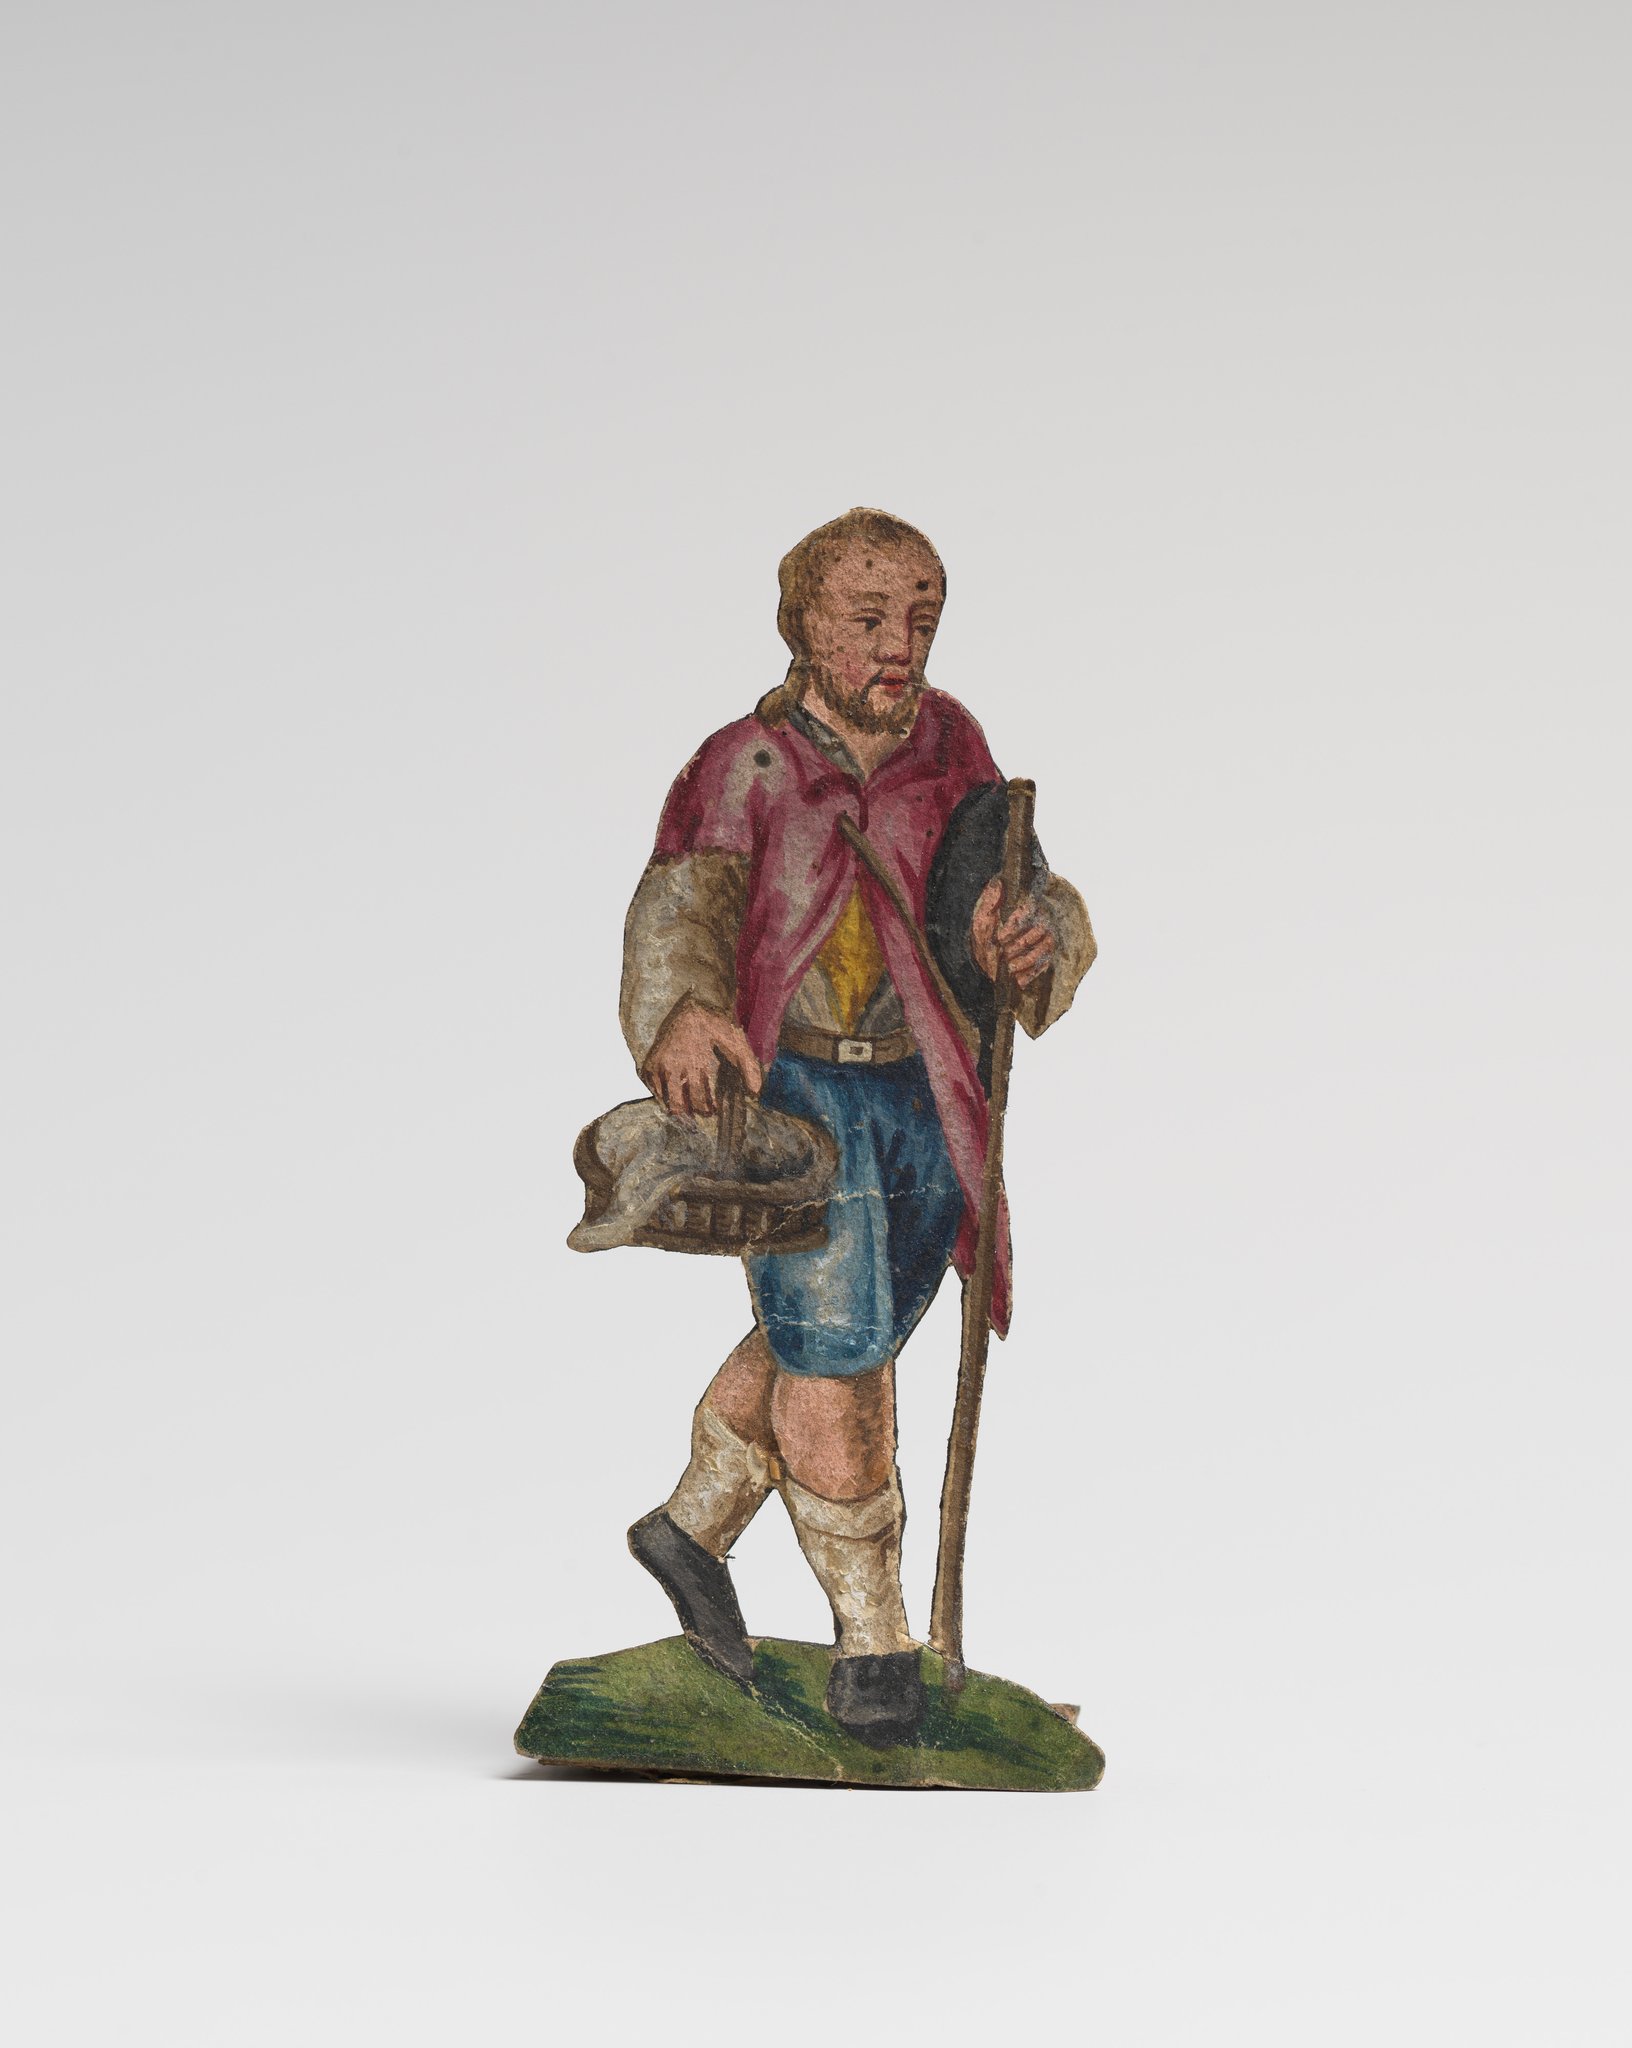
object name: figure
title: Shepherd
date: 1701-1800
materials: gouache, paper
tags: men,shepherds